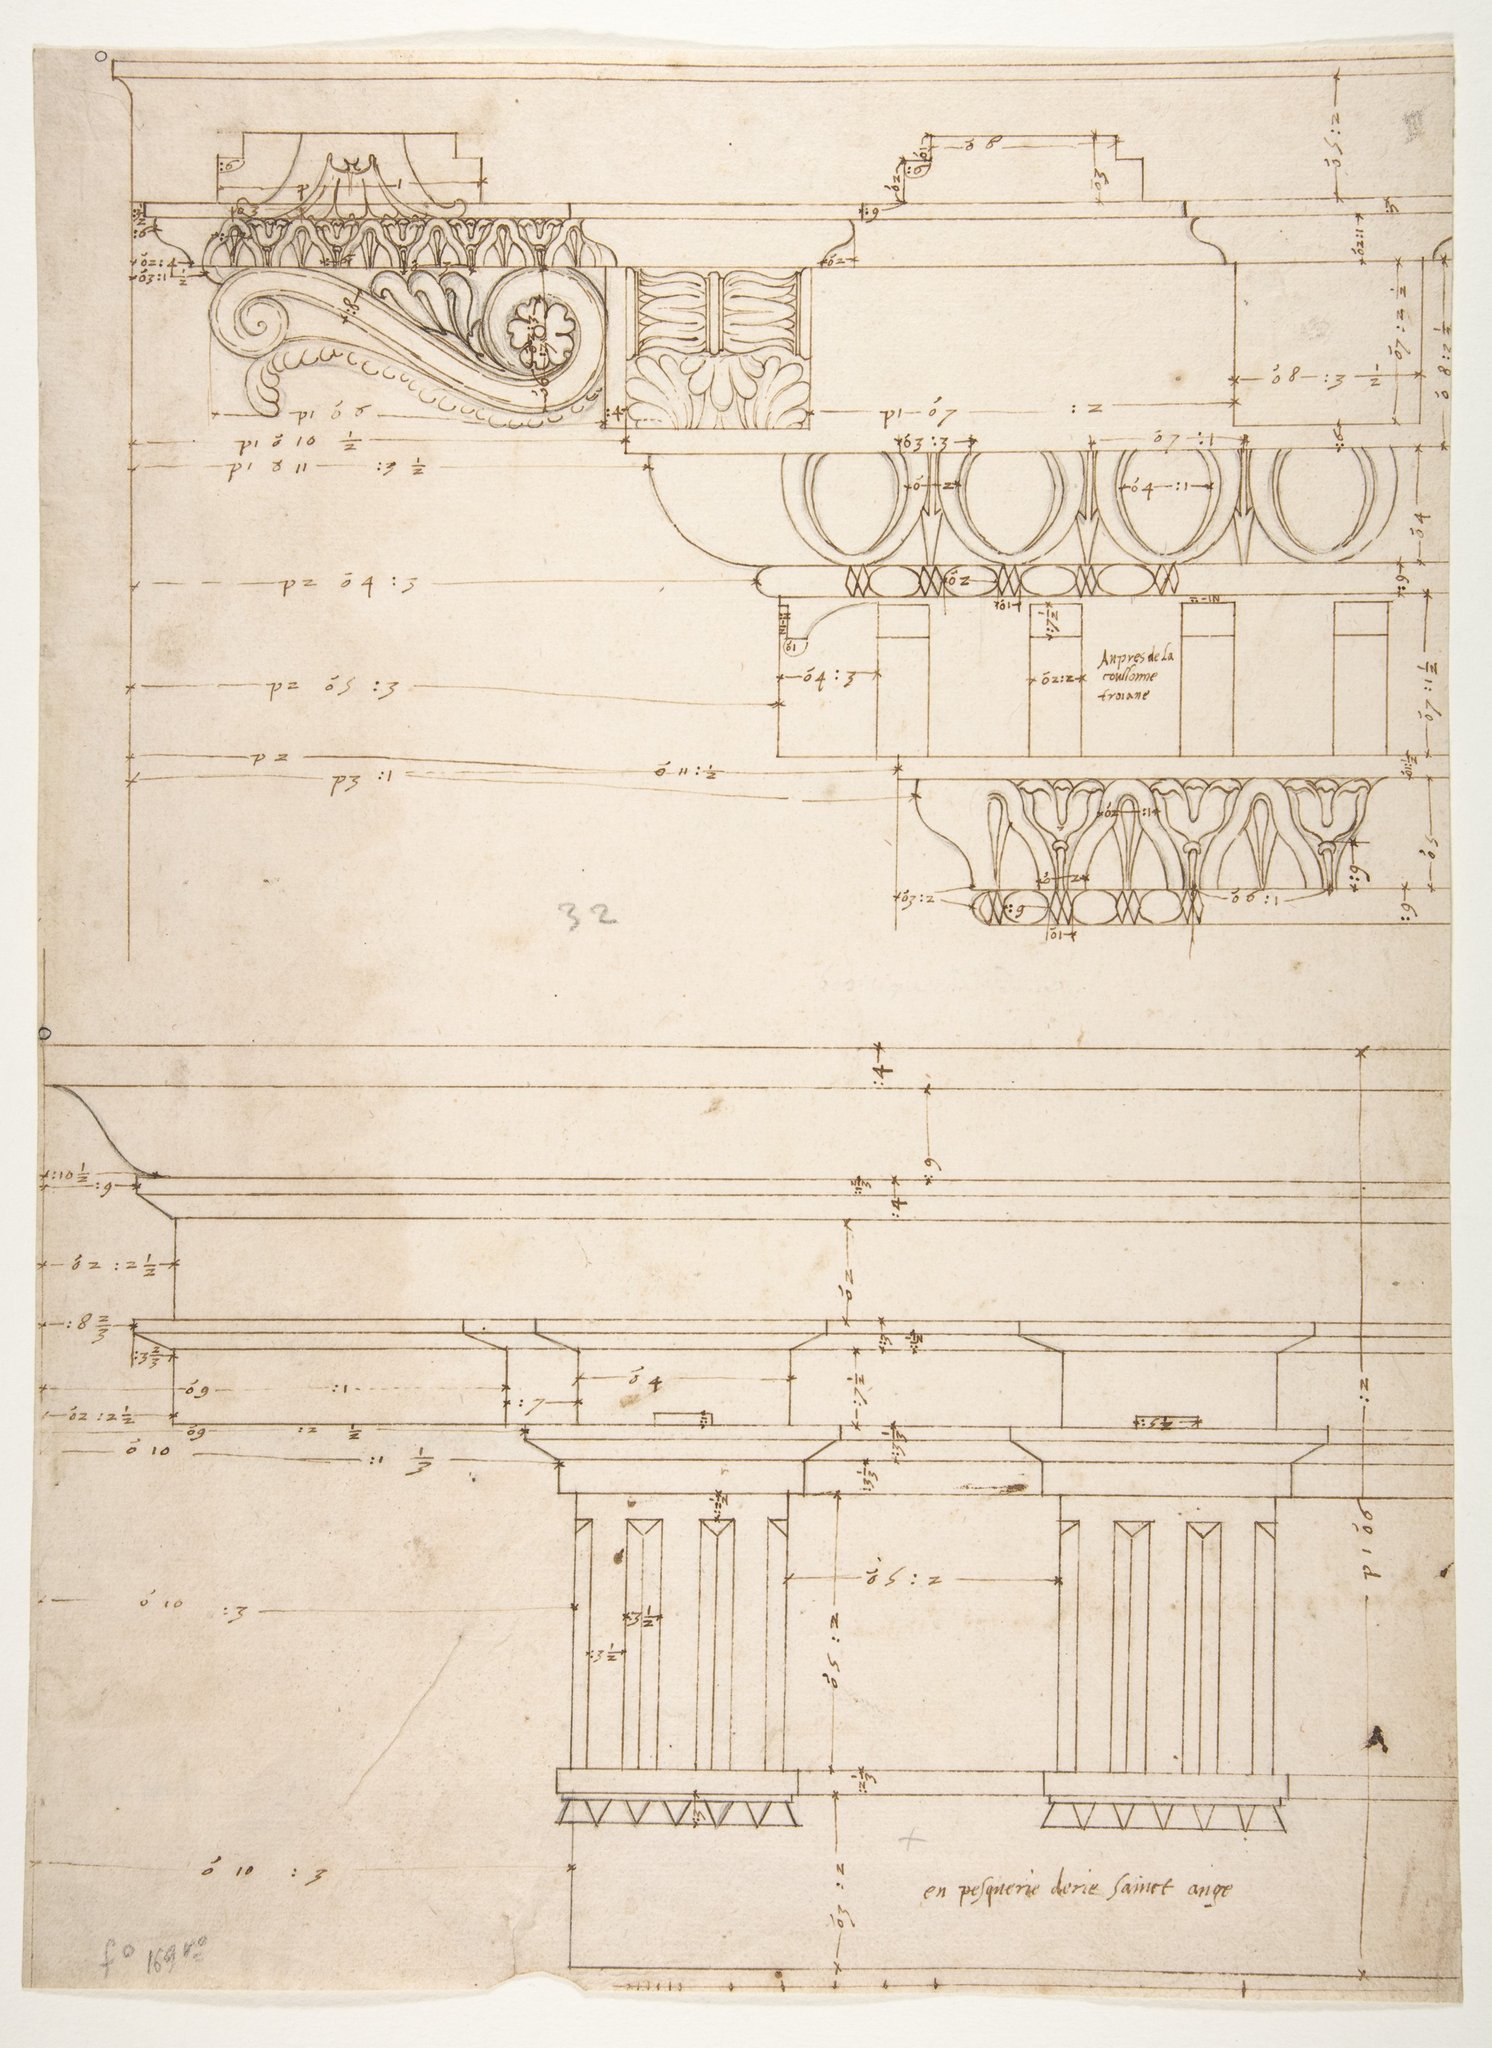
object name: collection ornament architecture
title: Basilica Ulpia, cornice, elevation profile with ornamental detailing; Domus Turciorum, entablature, elevation profile (recto) Domus Turciorum, elevation, perspective (verso)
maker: anonymous, french, 16th century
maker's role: draftsman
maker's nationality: french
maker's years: 1500-1600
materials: chalk, ink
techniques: incising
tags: architecture